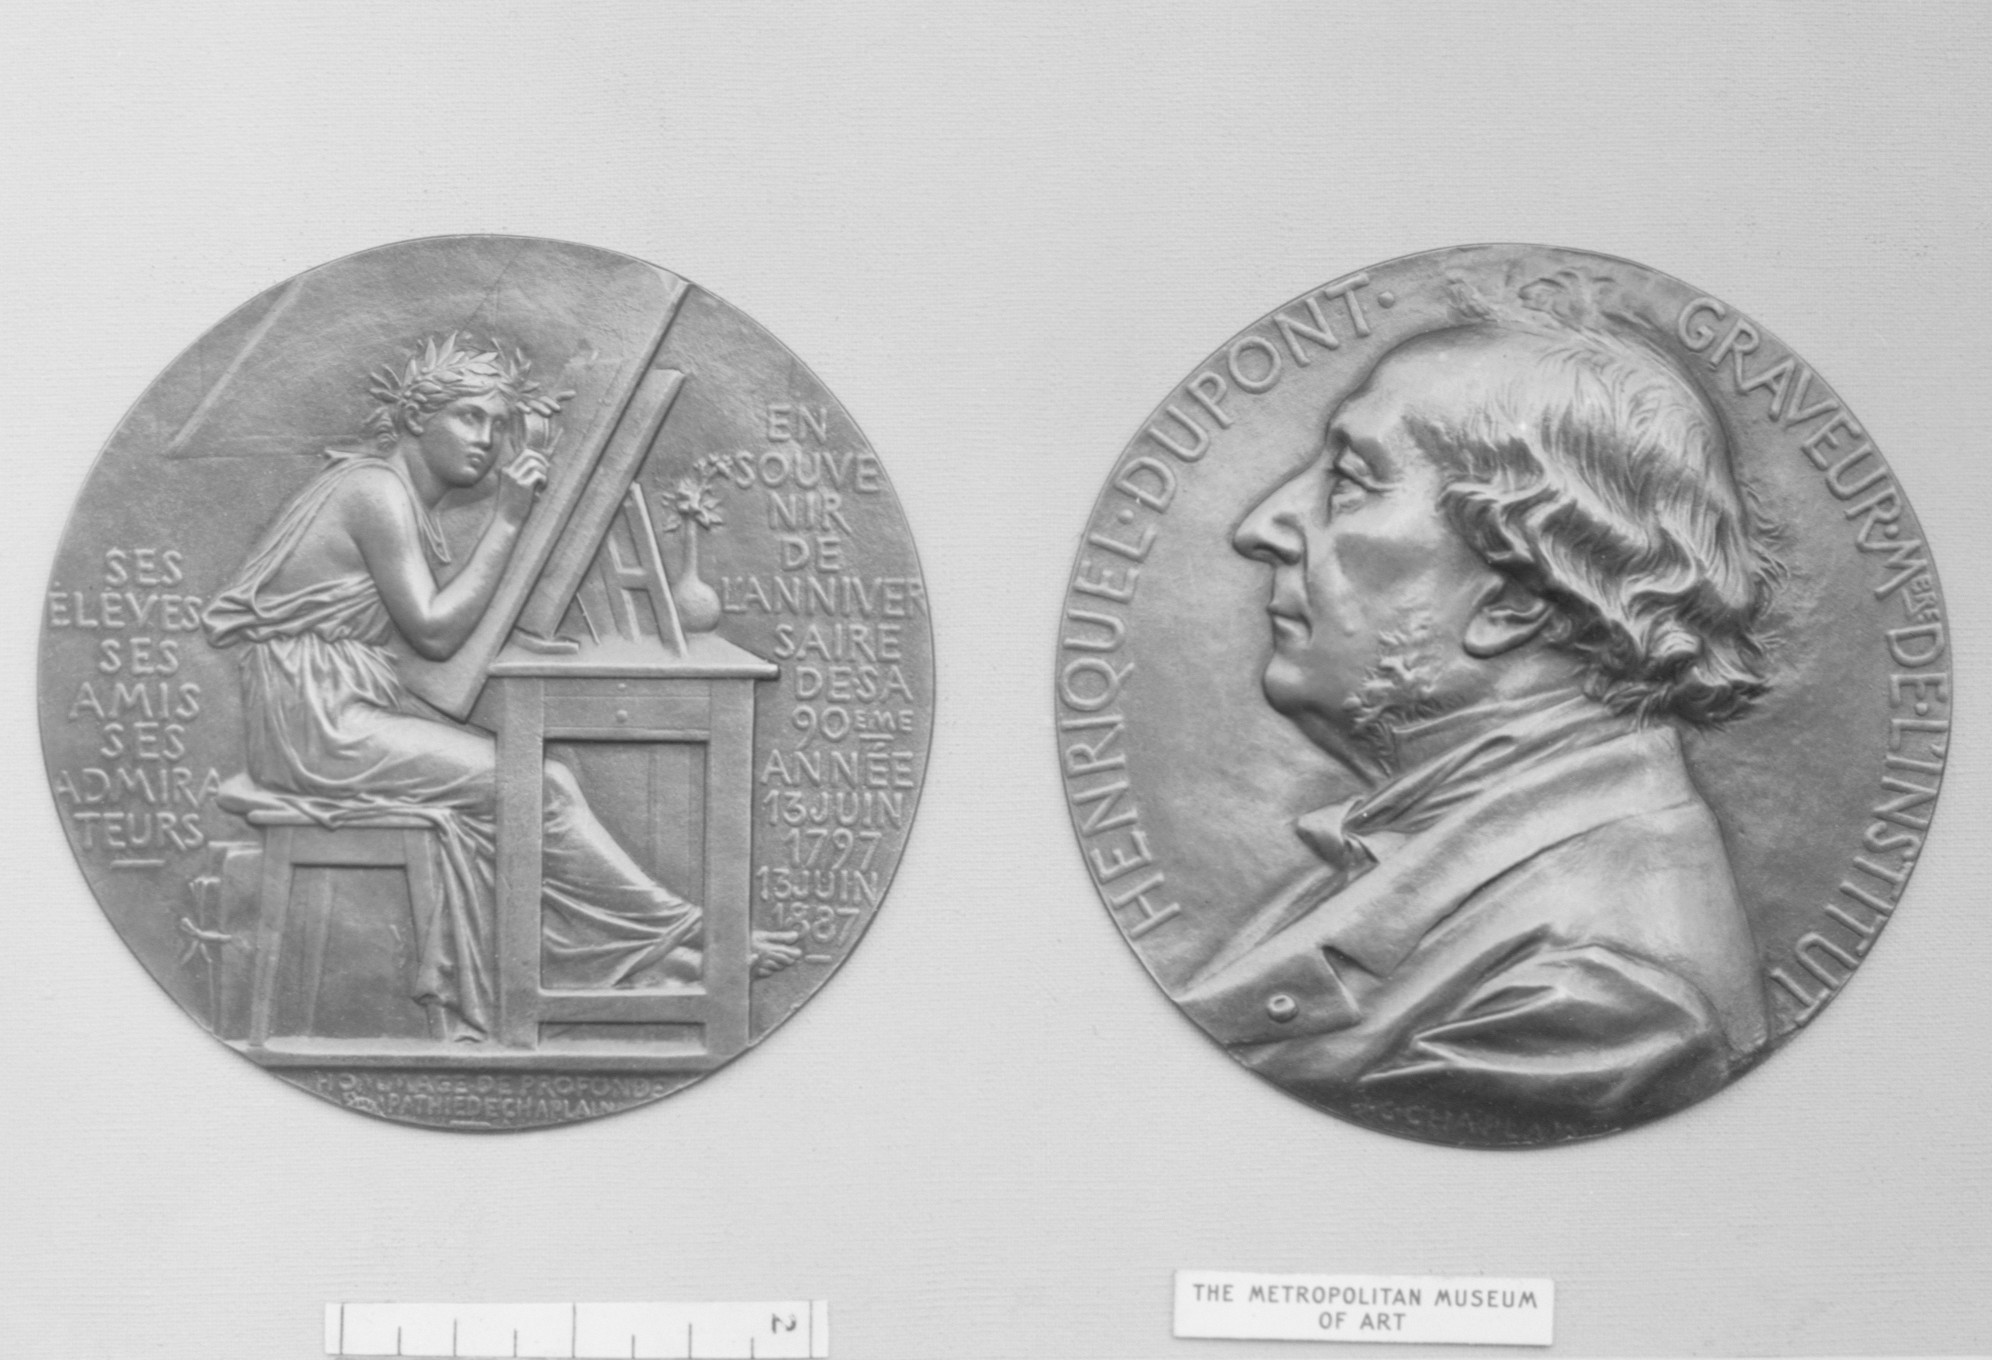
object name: medallion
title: In honor of M. Henriquel-Dupont, Engraver, etc. (1887)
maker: jules-clément chaplain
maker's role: artist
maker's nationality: french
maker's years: 1839-1909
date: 1887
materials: bronze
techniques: casting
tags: men,profiles